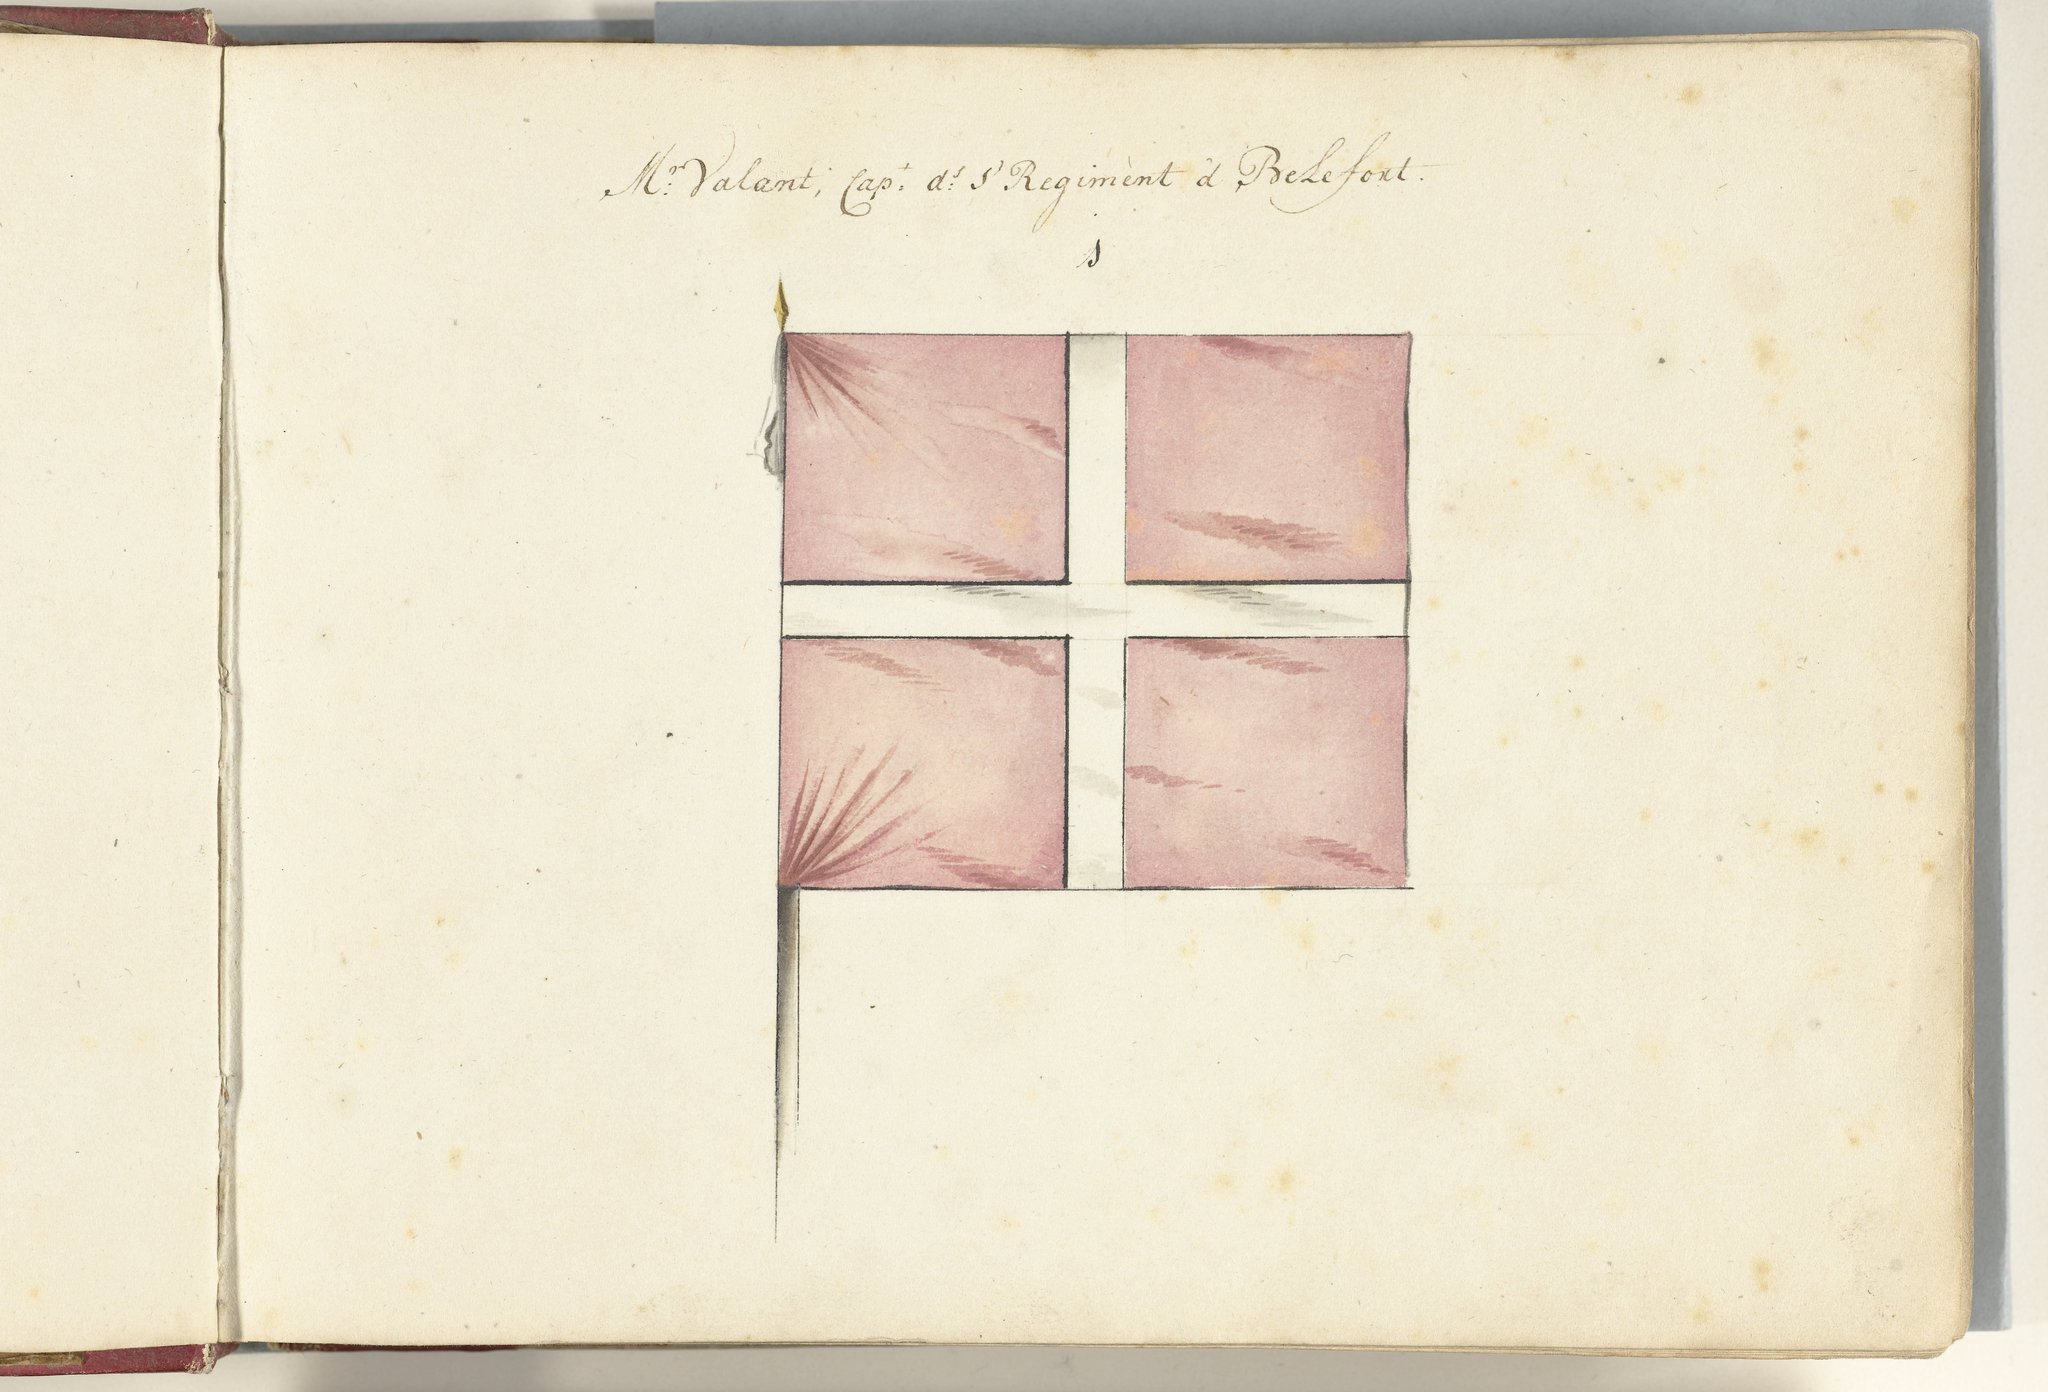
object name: drawing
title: Frans vaandel veroverd in de slag bij Spierbach, 1703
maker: Anonymous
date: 1713-1720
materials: paper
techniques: drawing, writing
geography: northern netherlands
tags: (military) flags and standards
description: Frans vaandel veroverd in de slag bij Spierbach, 1703. In het boek met tekeningen van Franse vaandels, standaarden en pauken, veroverd tijdens de Spaanse Successieoorlog (1701-1713).